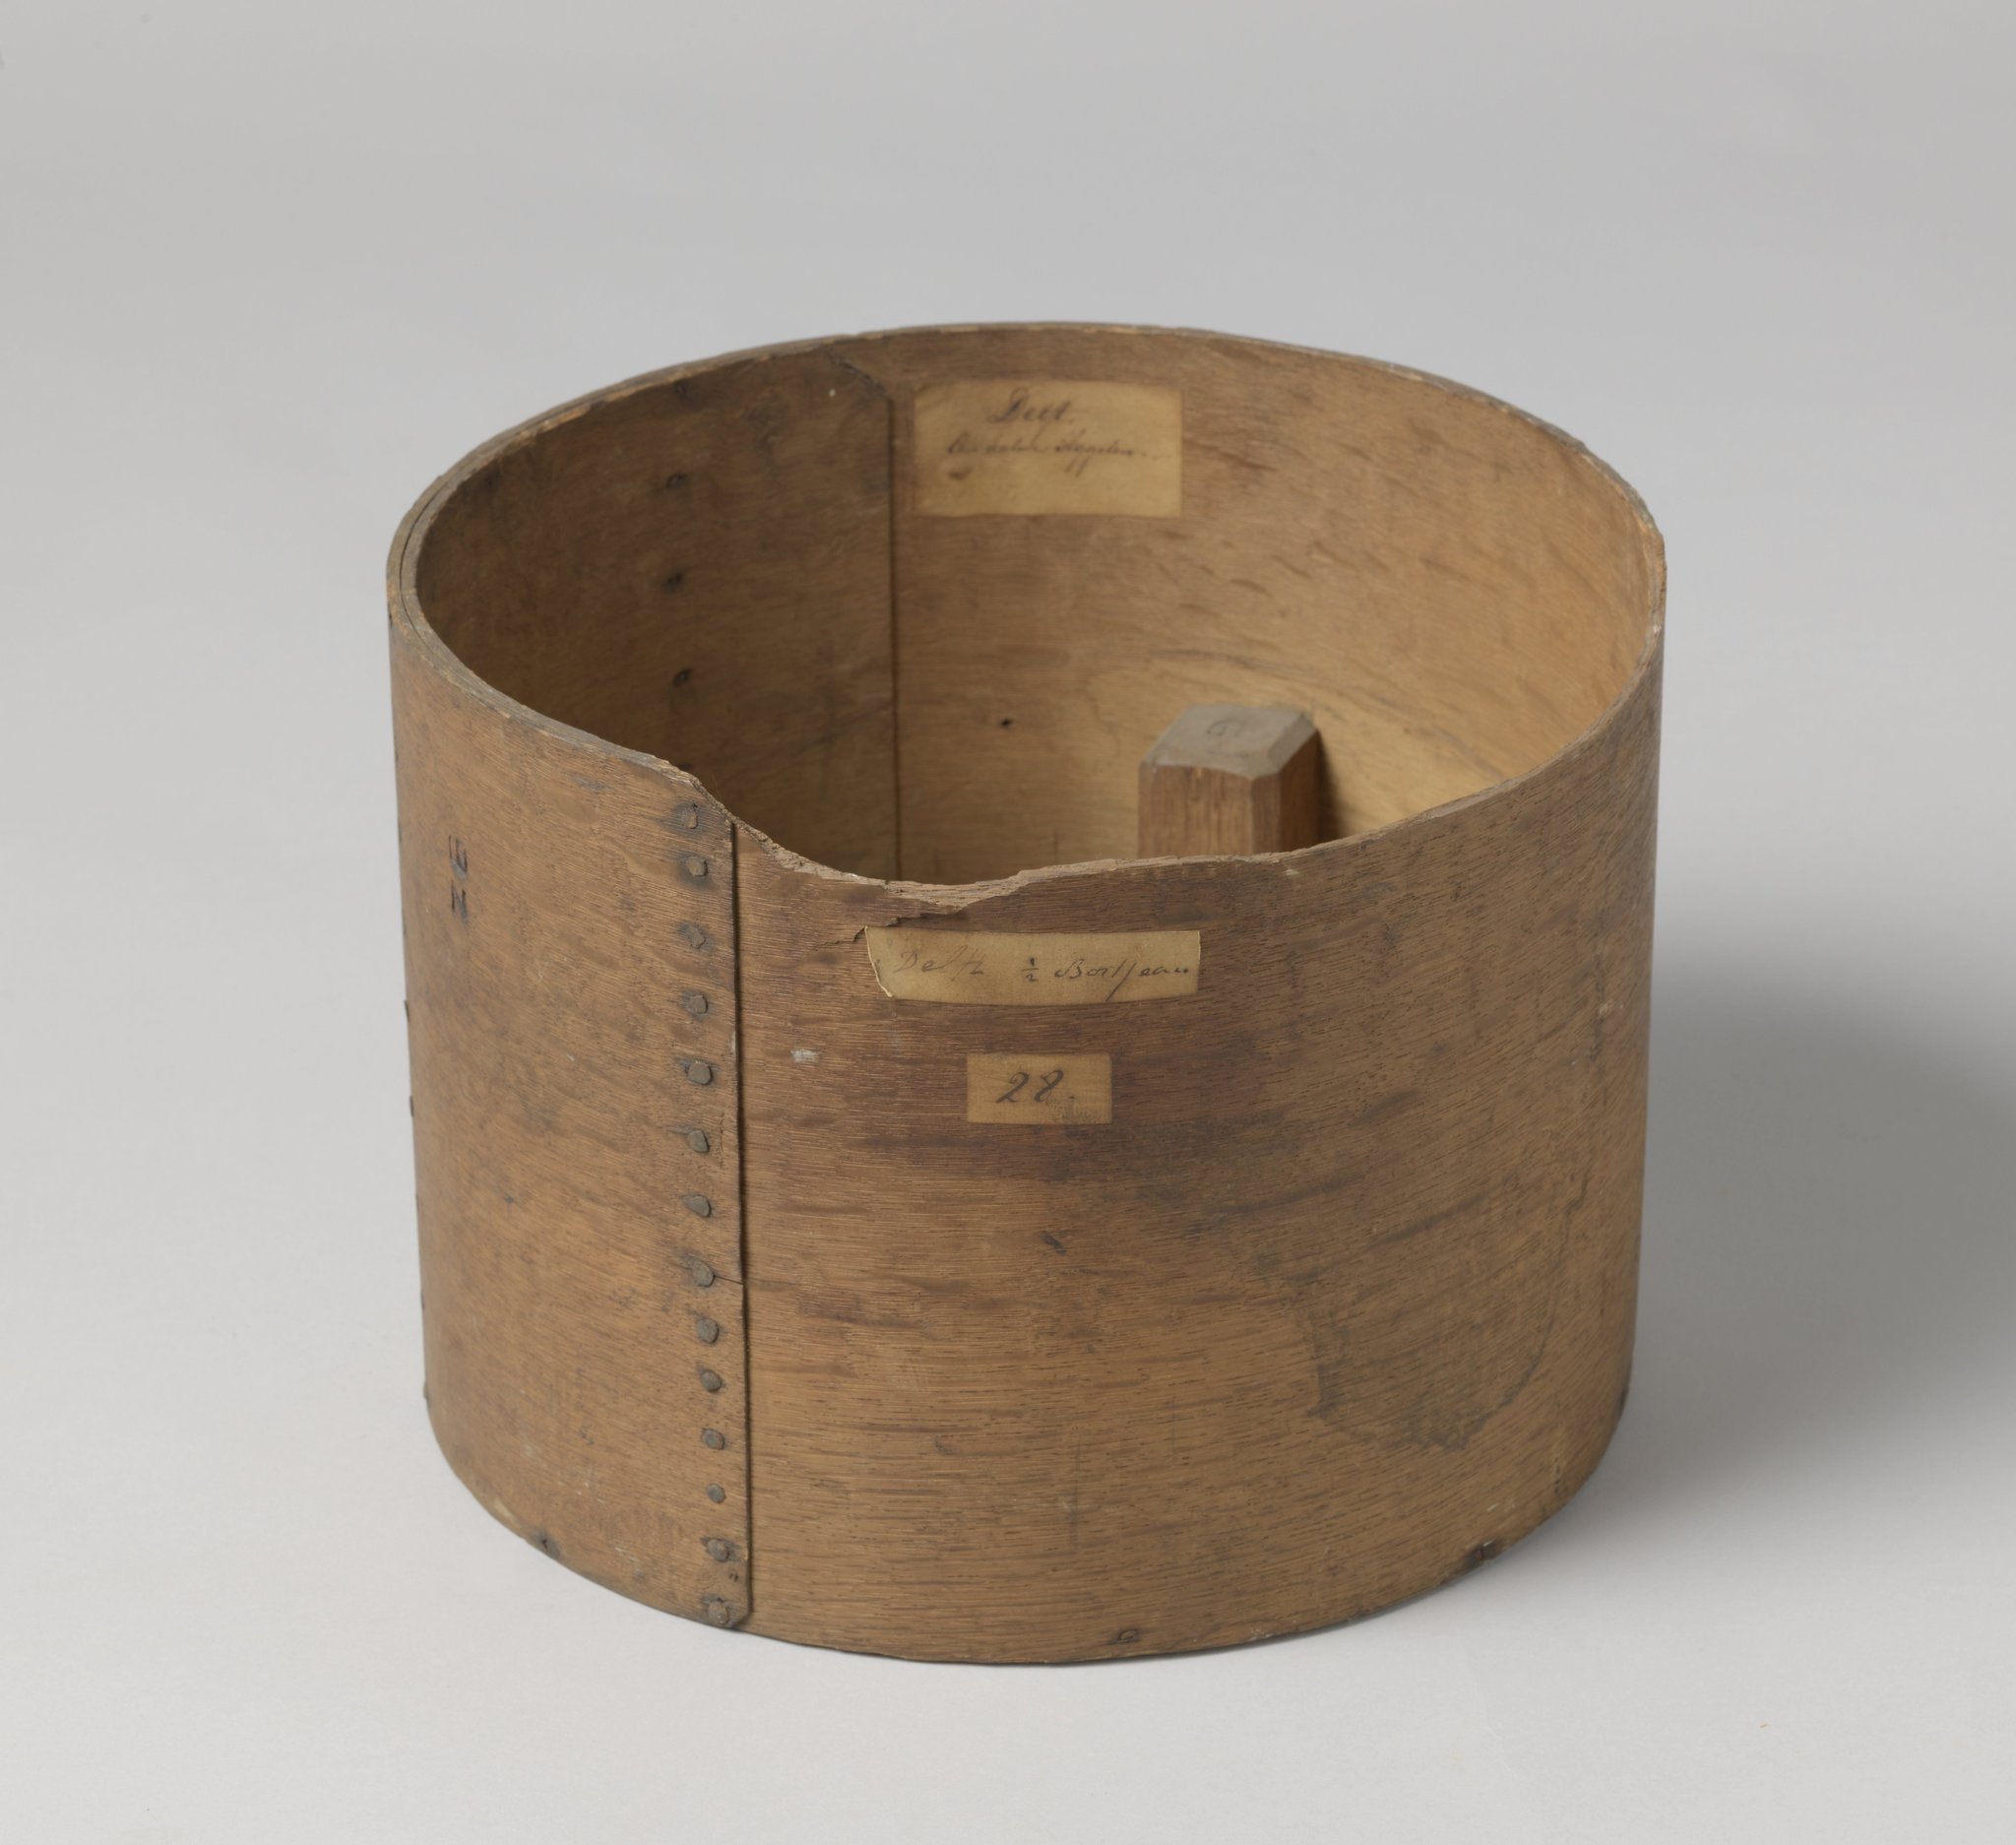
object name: inhoudsmaat droge waren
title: Dubbele aggele uit Delft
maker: Anonymous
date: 1800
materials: wood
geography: delft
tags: delft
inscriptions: title: ‘Delft Een halve Aggelen’, title: ‘de Delft 1/2 Boisseau 28’, mark: ‘N’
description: Spanen inhoudsmaat voor droge waren van een dubbele aggele, gemerkt en v.z.v. etiketten.